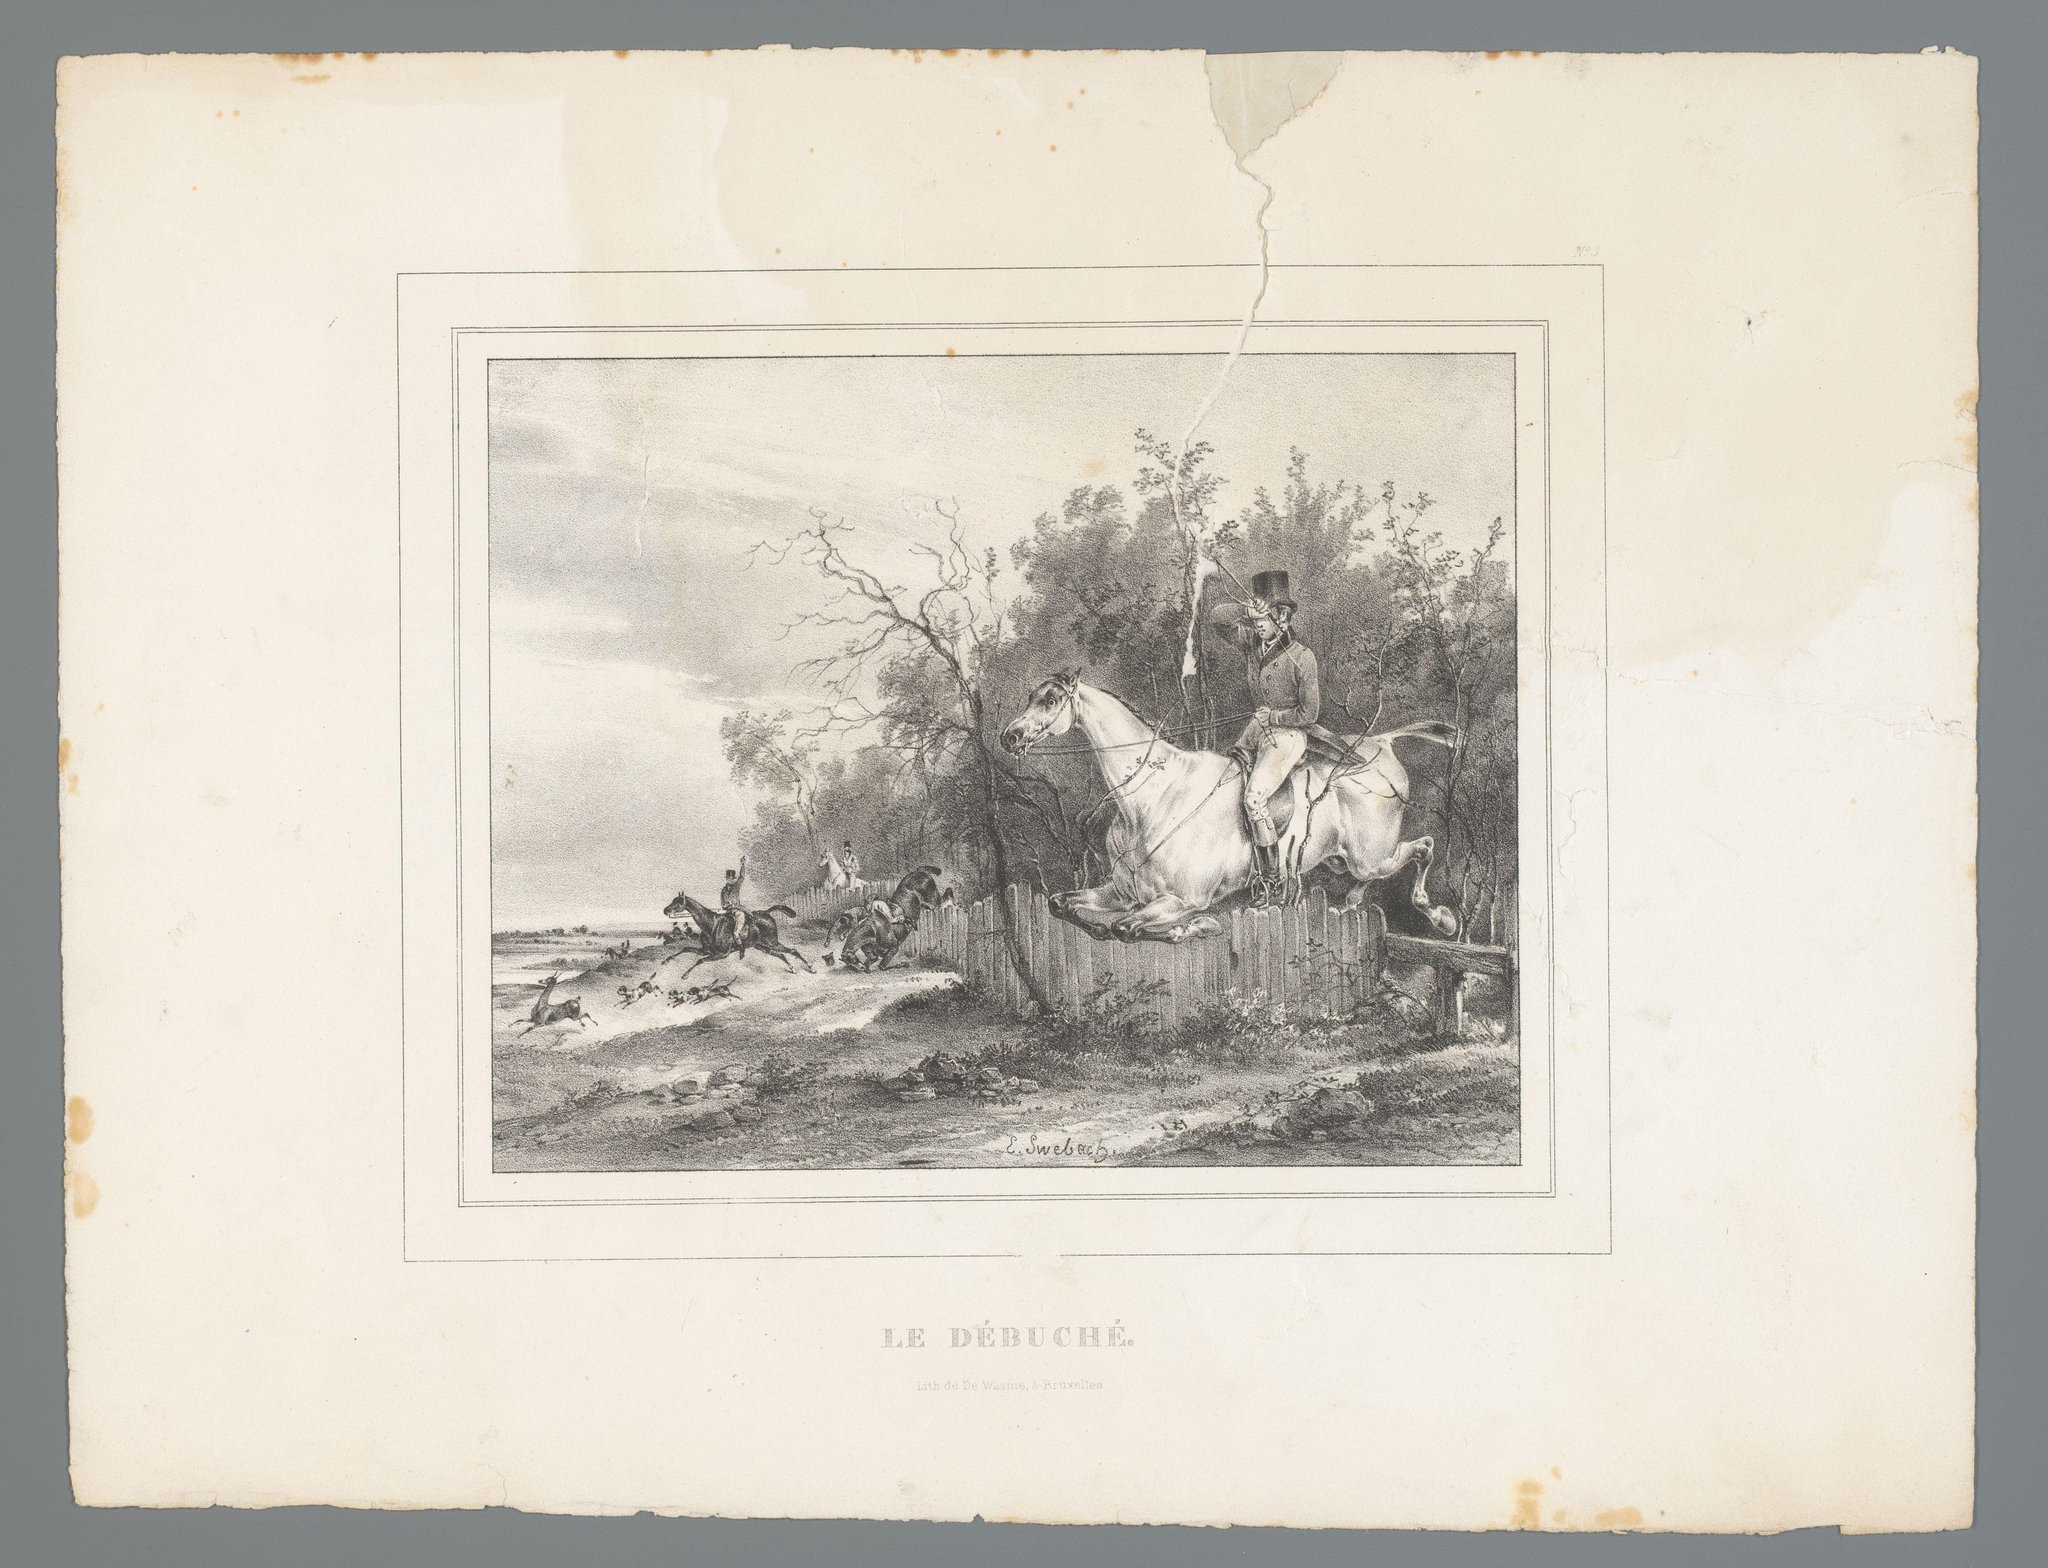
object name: print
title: Ongemakken van de drijfjacht met paarden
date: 1825-1827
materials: paper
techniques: lithograph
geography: brussels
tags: hunting, chase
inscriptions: collector's mark: Lugt 2228